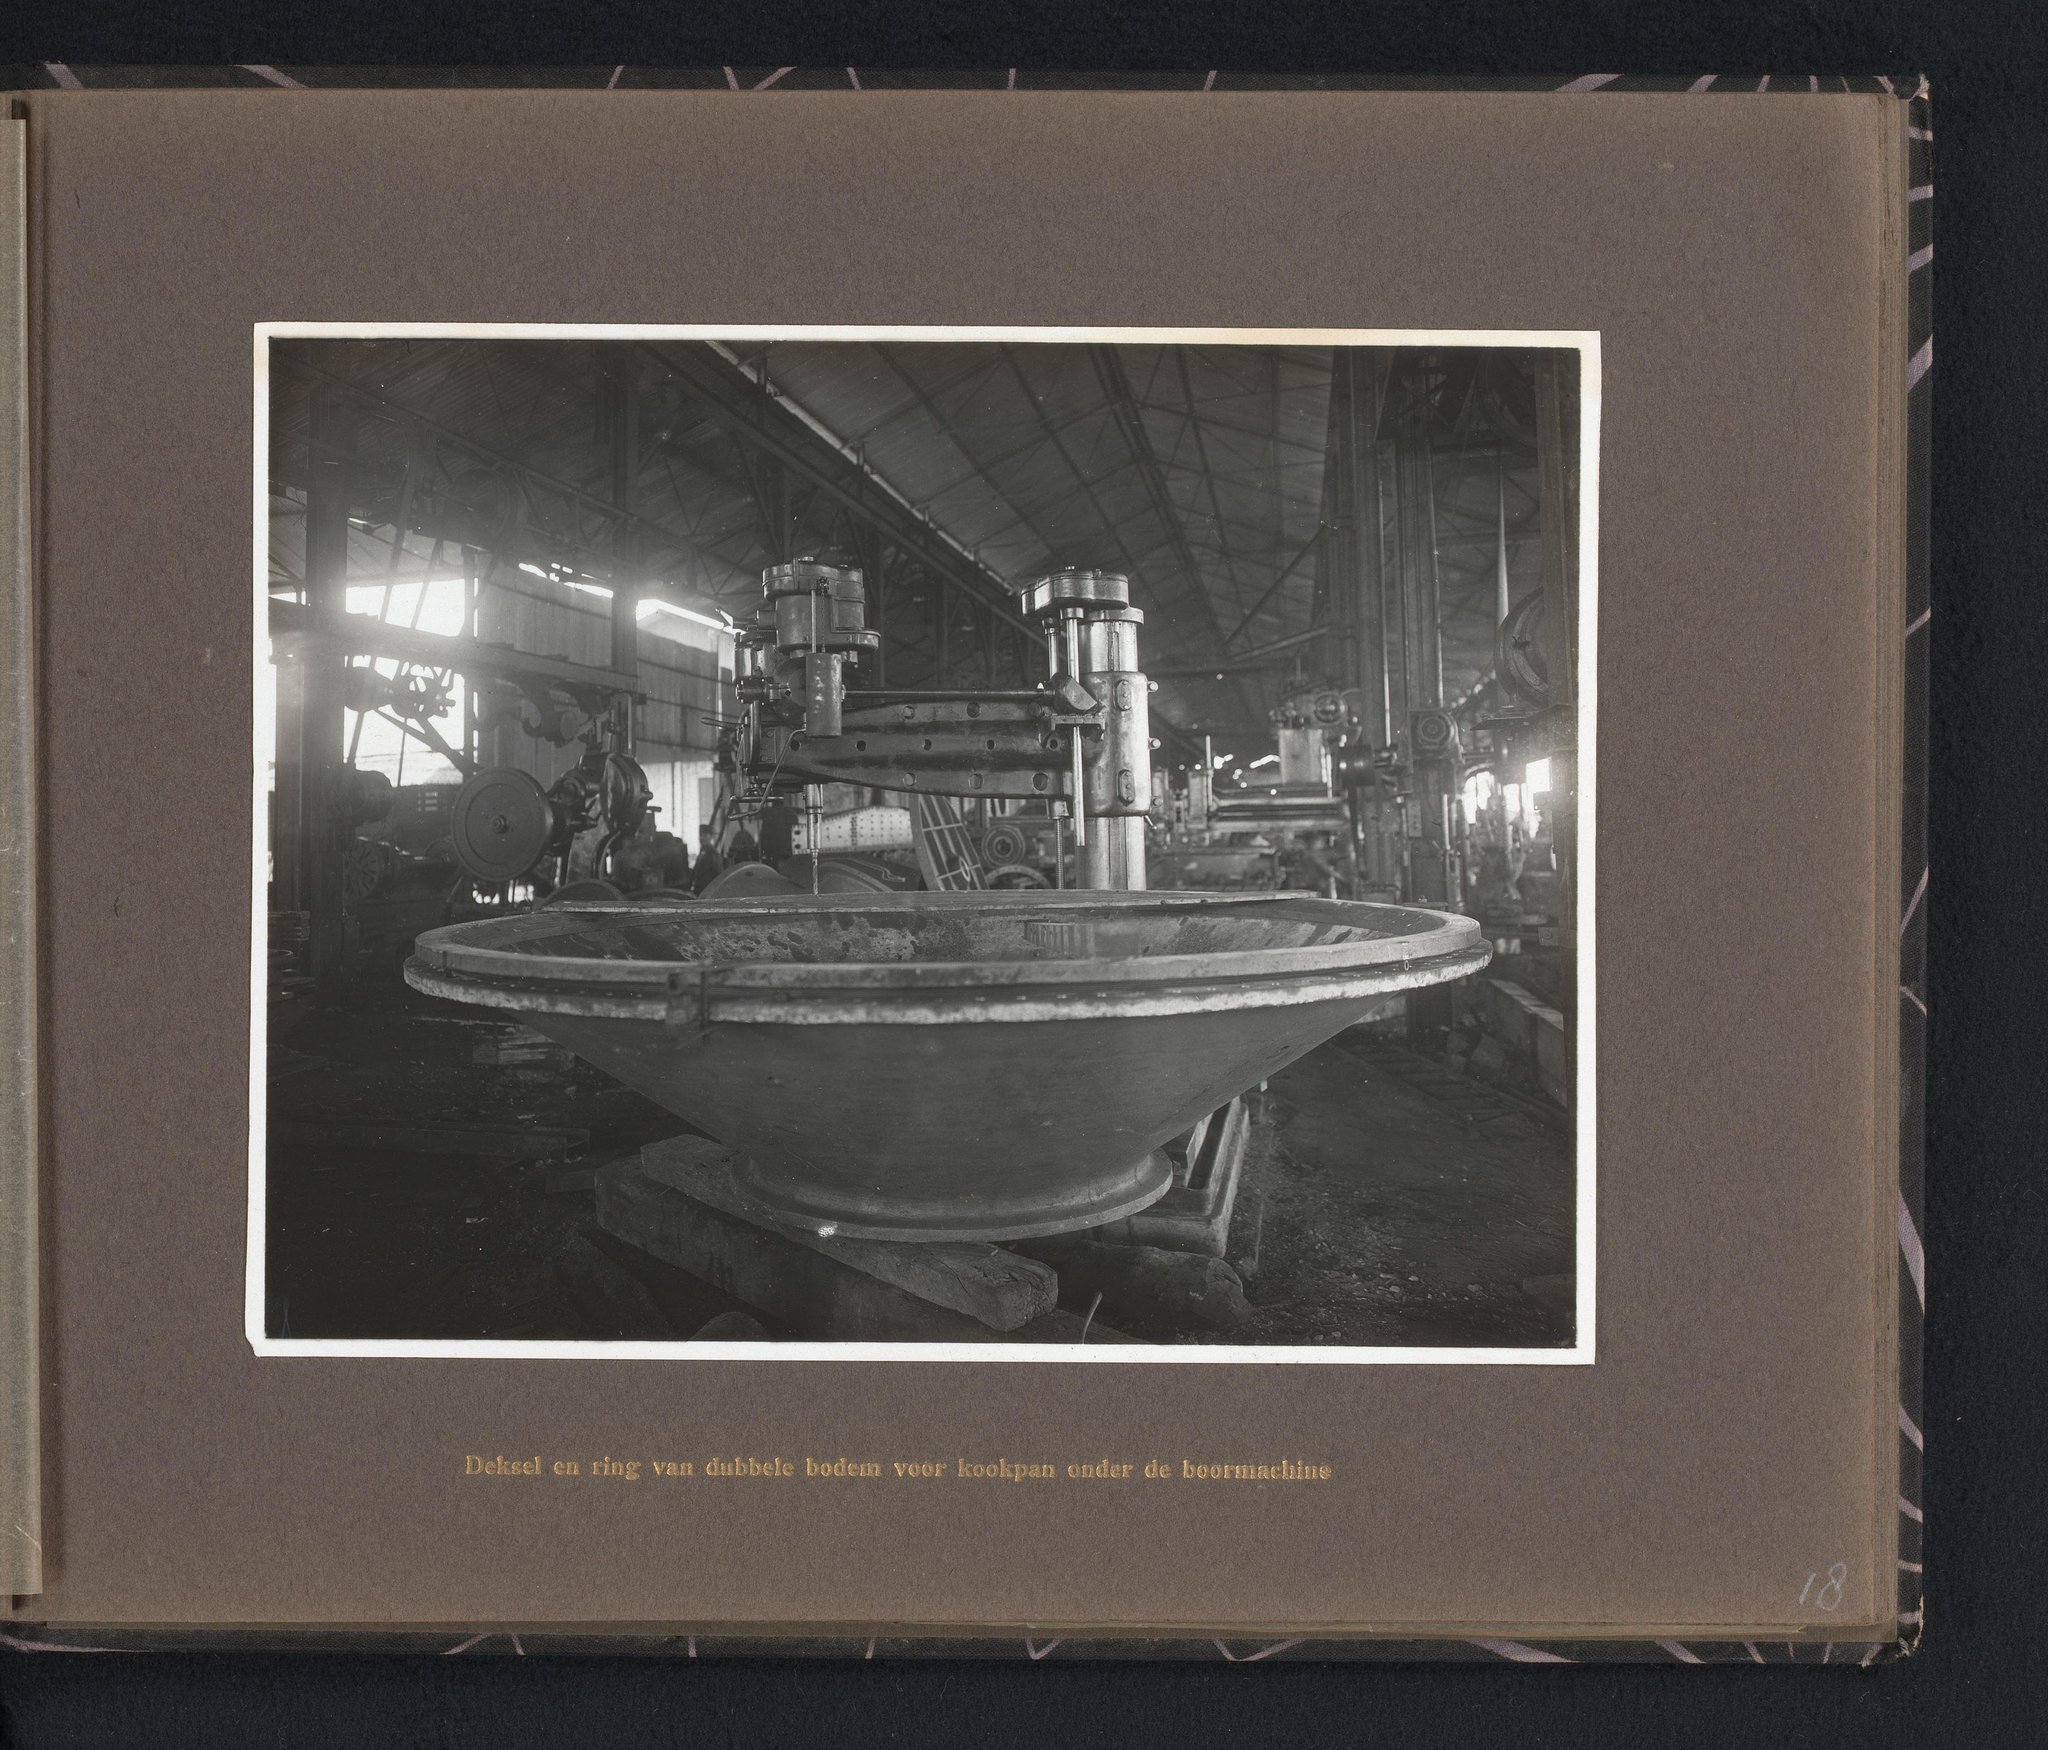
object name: photograph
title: Deksel en ring van dubbele bodem voor kookpan onder de boormachine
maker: Anonymous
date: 1916-1924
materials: cardboard, photographic support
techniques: gelatin silver print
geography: surabaya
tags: colonial system, factory-interior, machine shop, machines; parts of machines; tools and appliances, java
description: Albumblad met een foto van een onderdeel van een ketel. Vervaardigd door Machinefabriek Braat. Onderdeel van het fotoalbum Machinefabriek Braat Soerabaia-Djocja-Tegal, ca. 1916-1924.